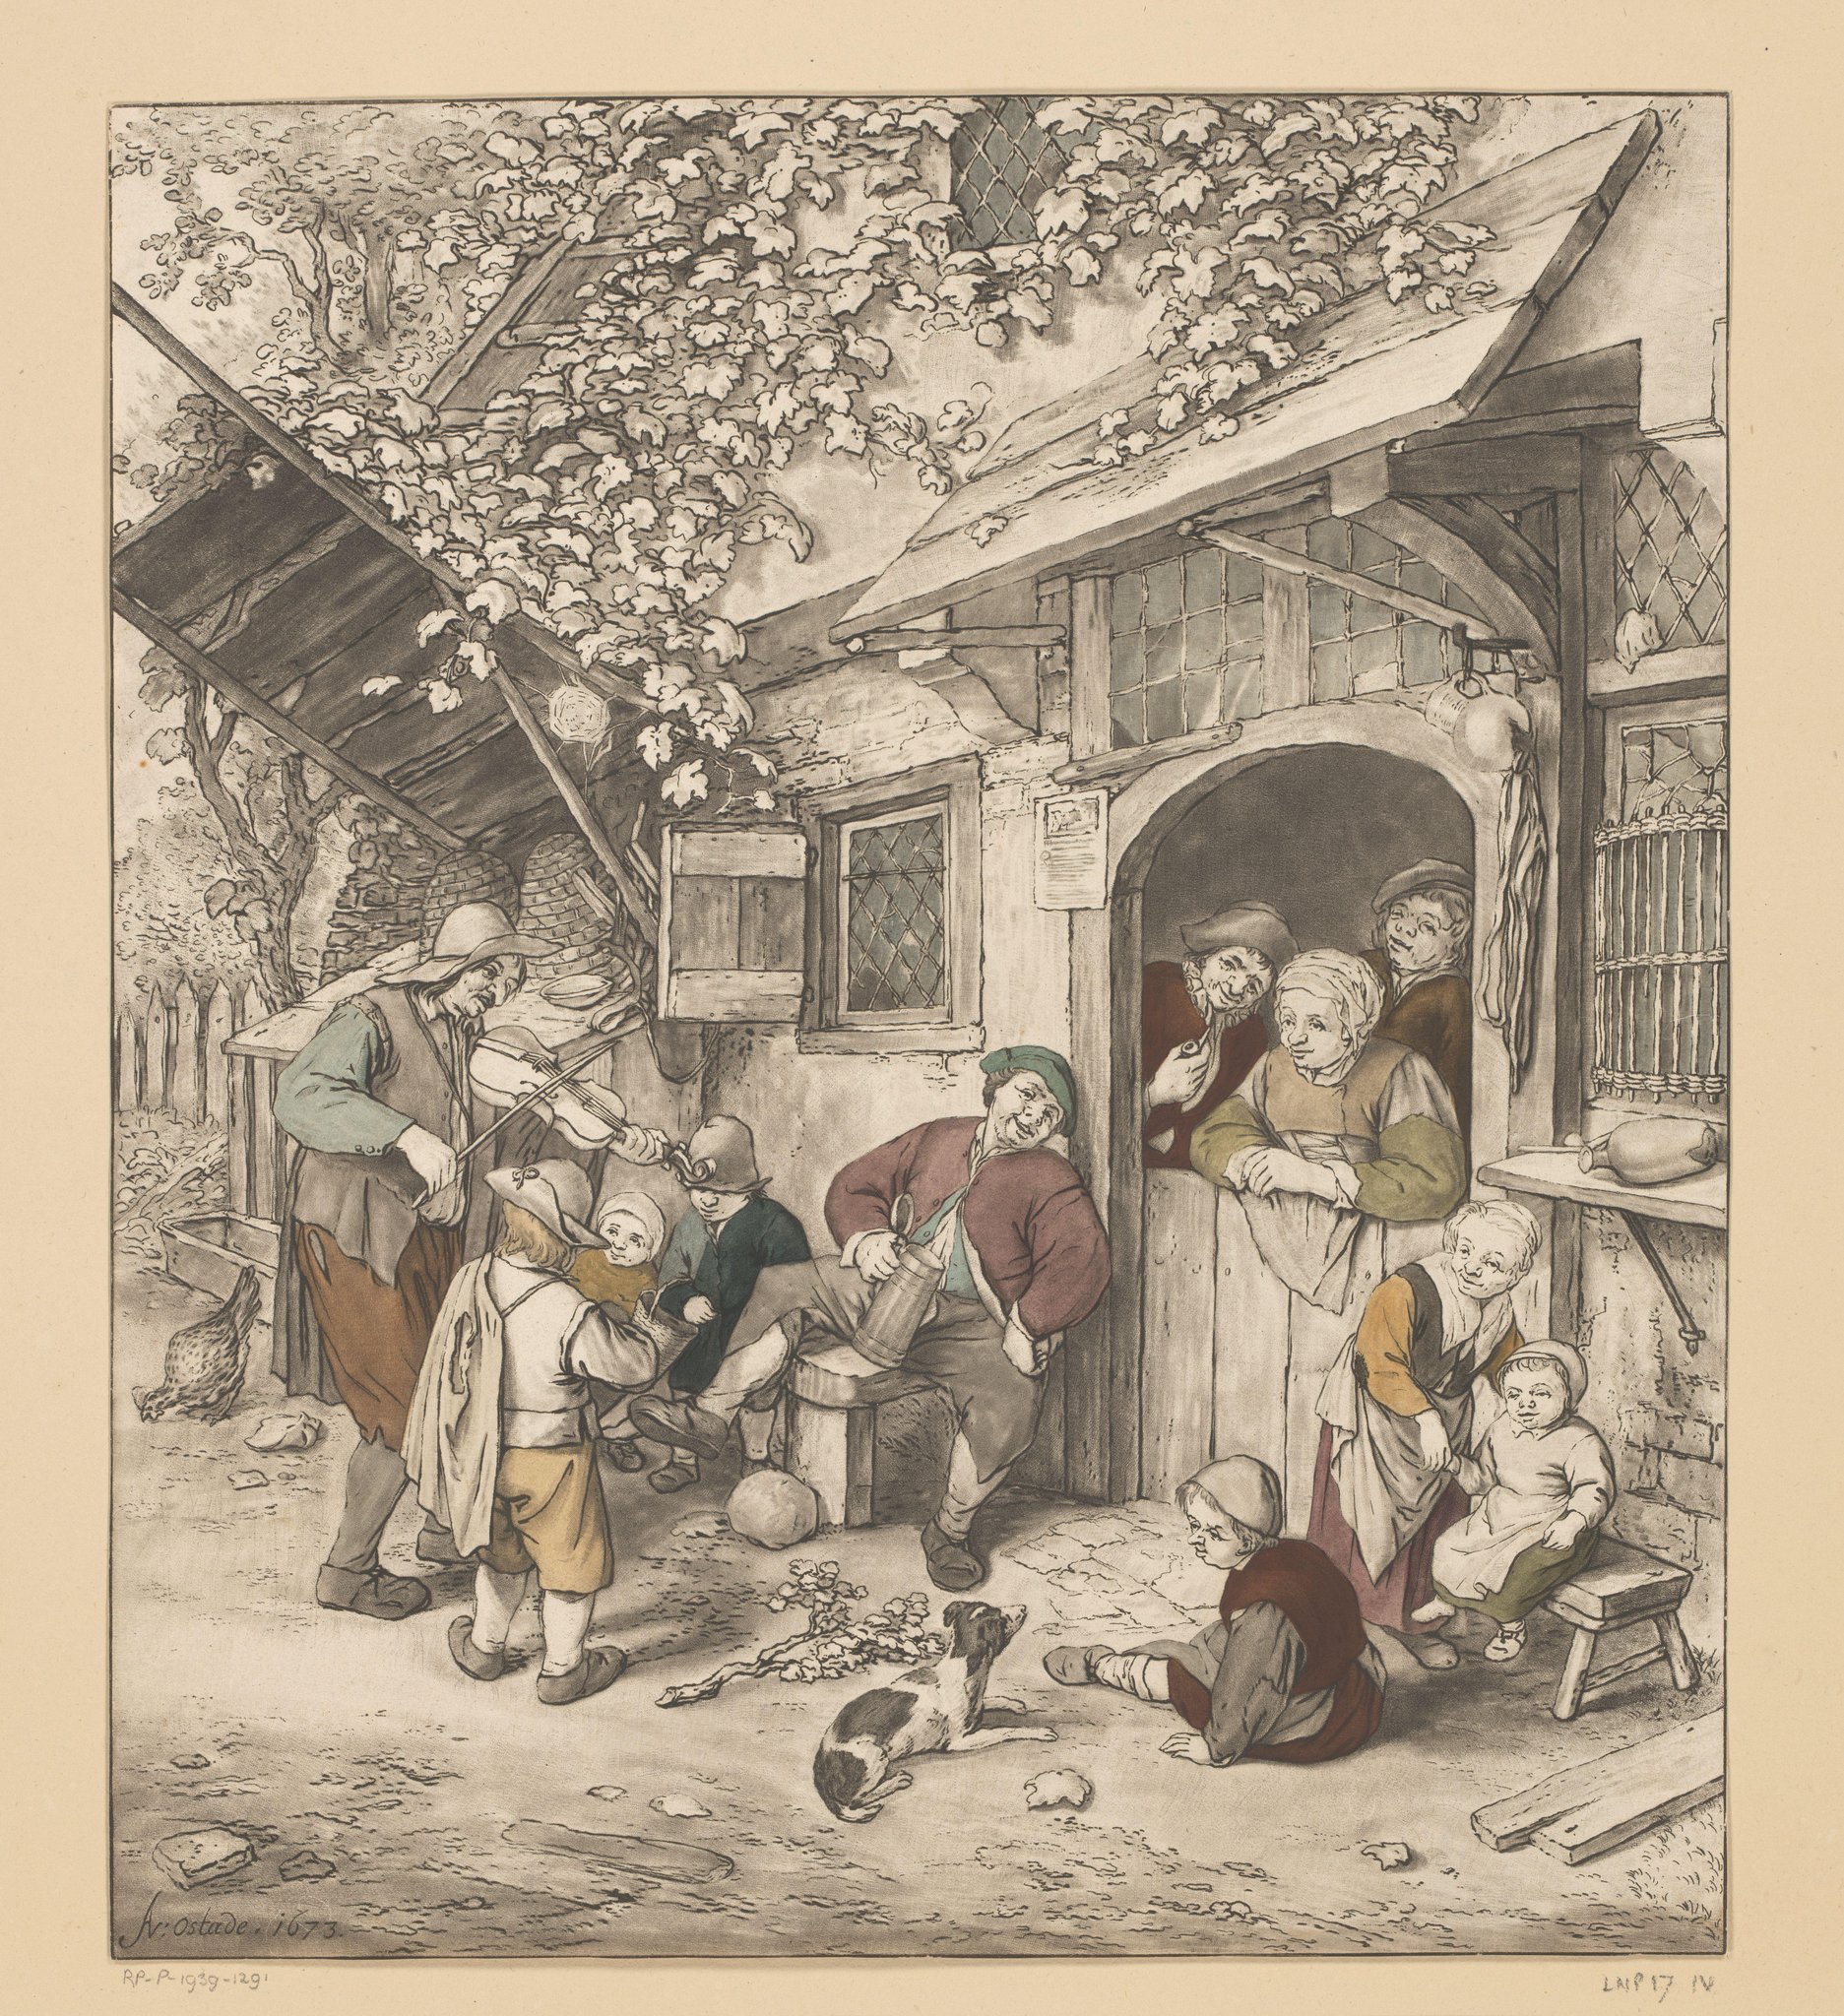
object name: print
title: Vioolspeler voor een herberg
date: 1766-1770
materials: paper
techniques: etching, hand coloring, roulette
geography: amsterdam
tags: one person playing string instrument (bowed), inn, coffee-house, public house, etc., dog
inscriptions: collector's mark: ‘RIJKS / MUSM’, collector's mark: Lugt 2725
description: Een man met viool en een jongen met draailier maken muziek bij een herberg. Volwassenen en kinderen luisteren. Een vrouw leunt over de onderdeur. De prent ligt los in een album, zie blad 17.